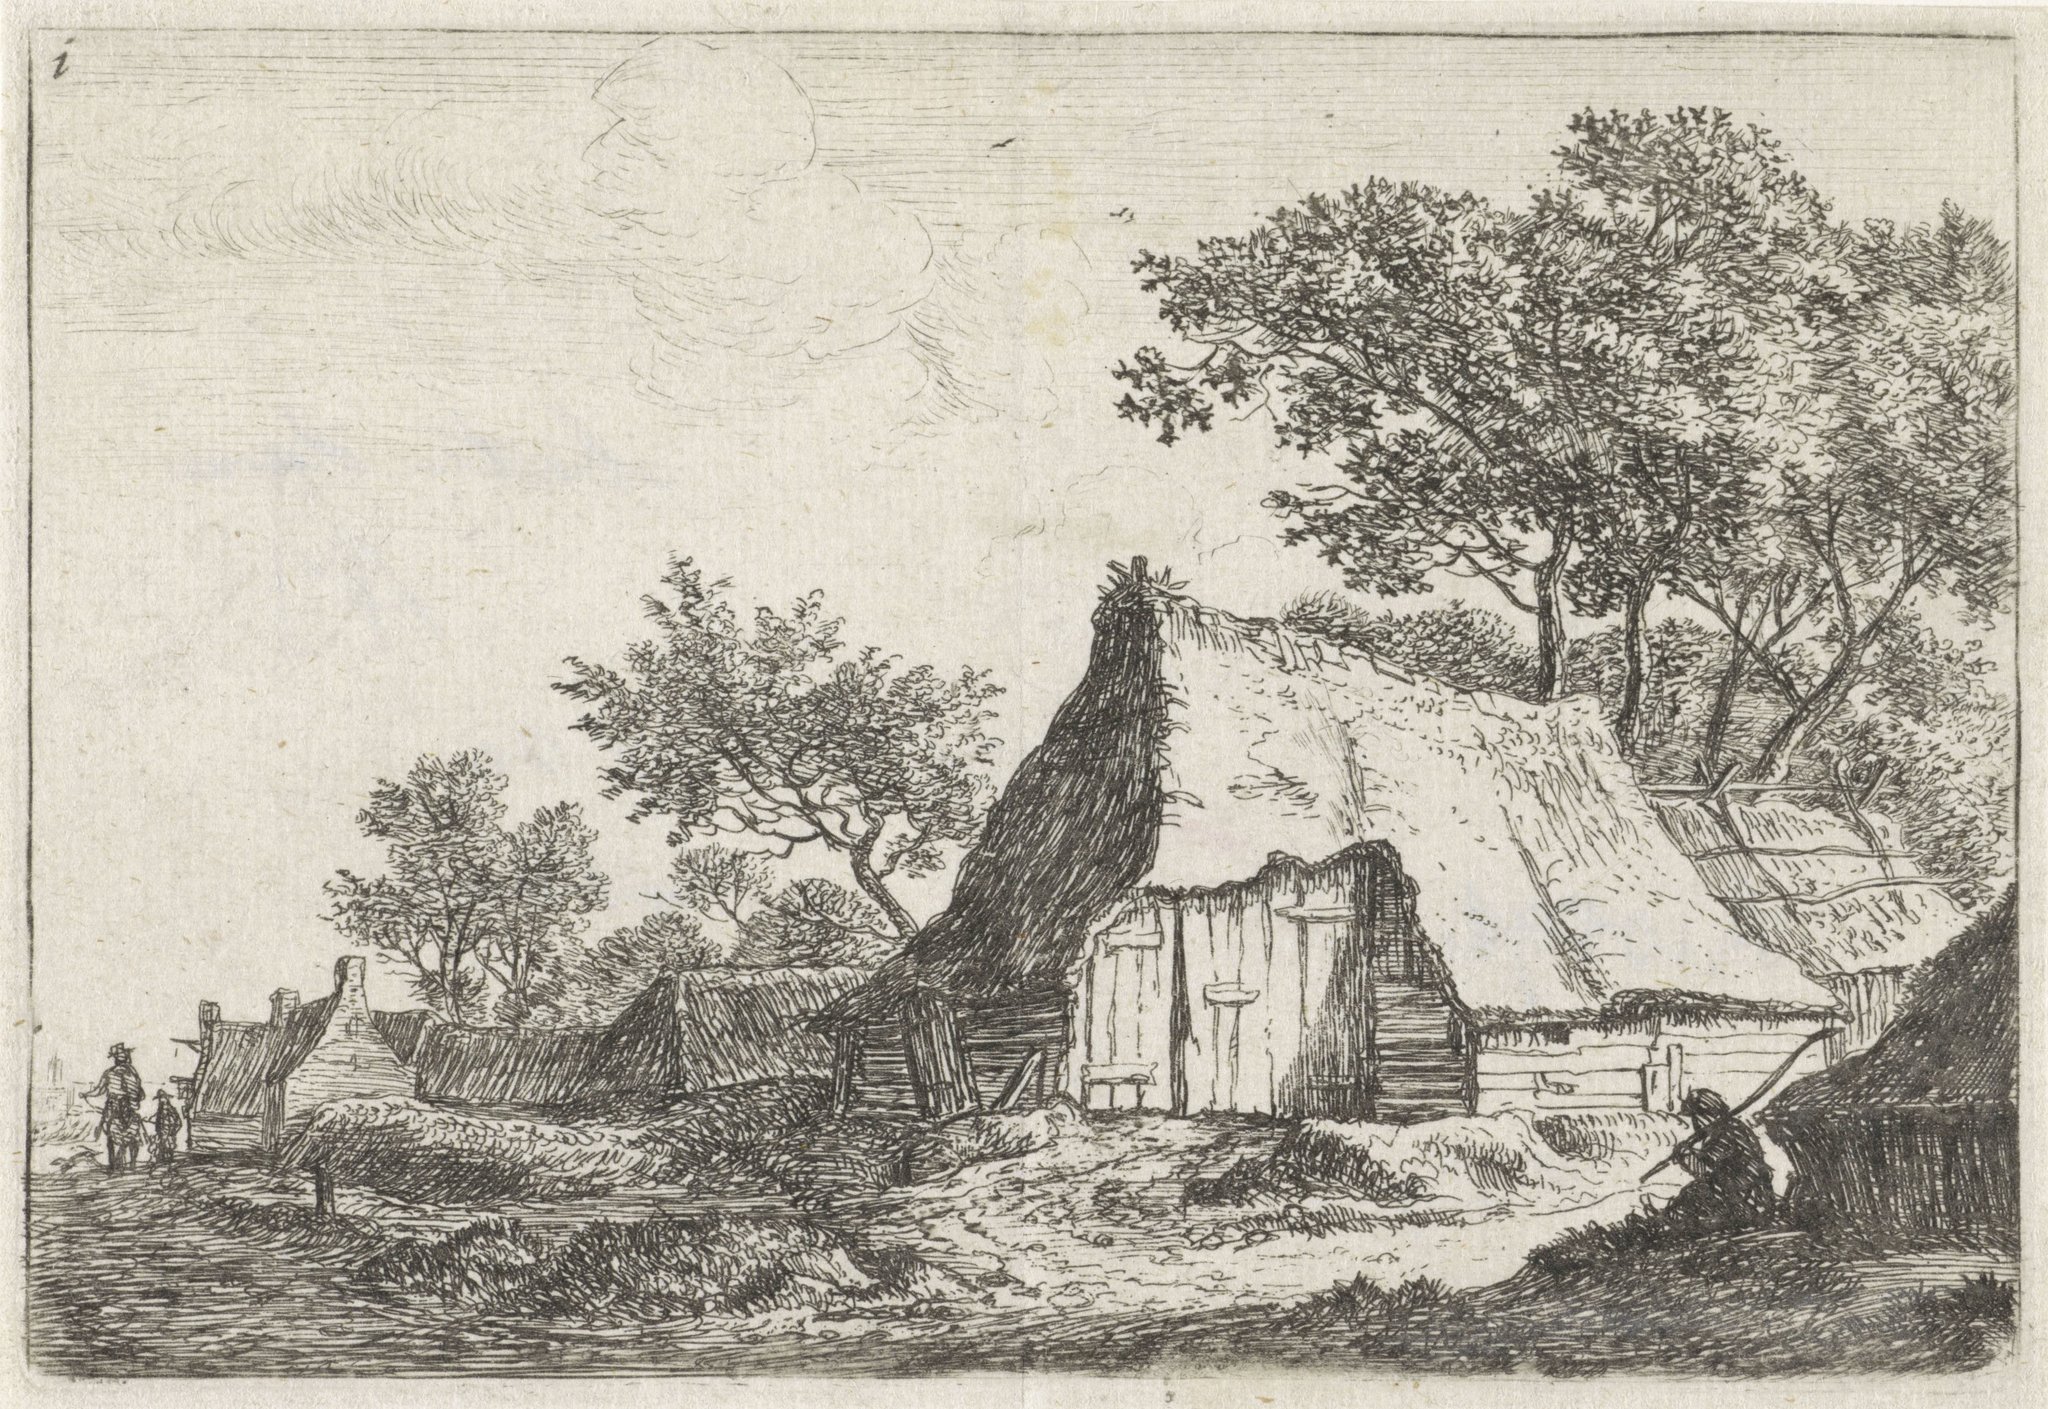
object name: print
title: Gezicht op een dorp met wandelaars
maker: anthonie waterloo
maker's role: draughtsman, painter, print maker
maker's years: 1609-1690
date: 1630-1663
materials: paper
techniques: etching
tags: walking, hiking (recreation), rural housing, e.g. country-house, villa, cottage, village, farm (building)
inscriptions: collector's mark: Lugt 2228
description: Er is een groep huizen langs een landweg weergegeven. Enkele huizen hebben een rieten dak. Links wandelen twee figuren met een hond. Linksboven is de letter i te zien.